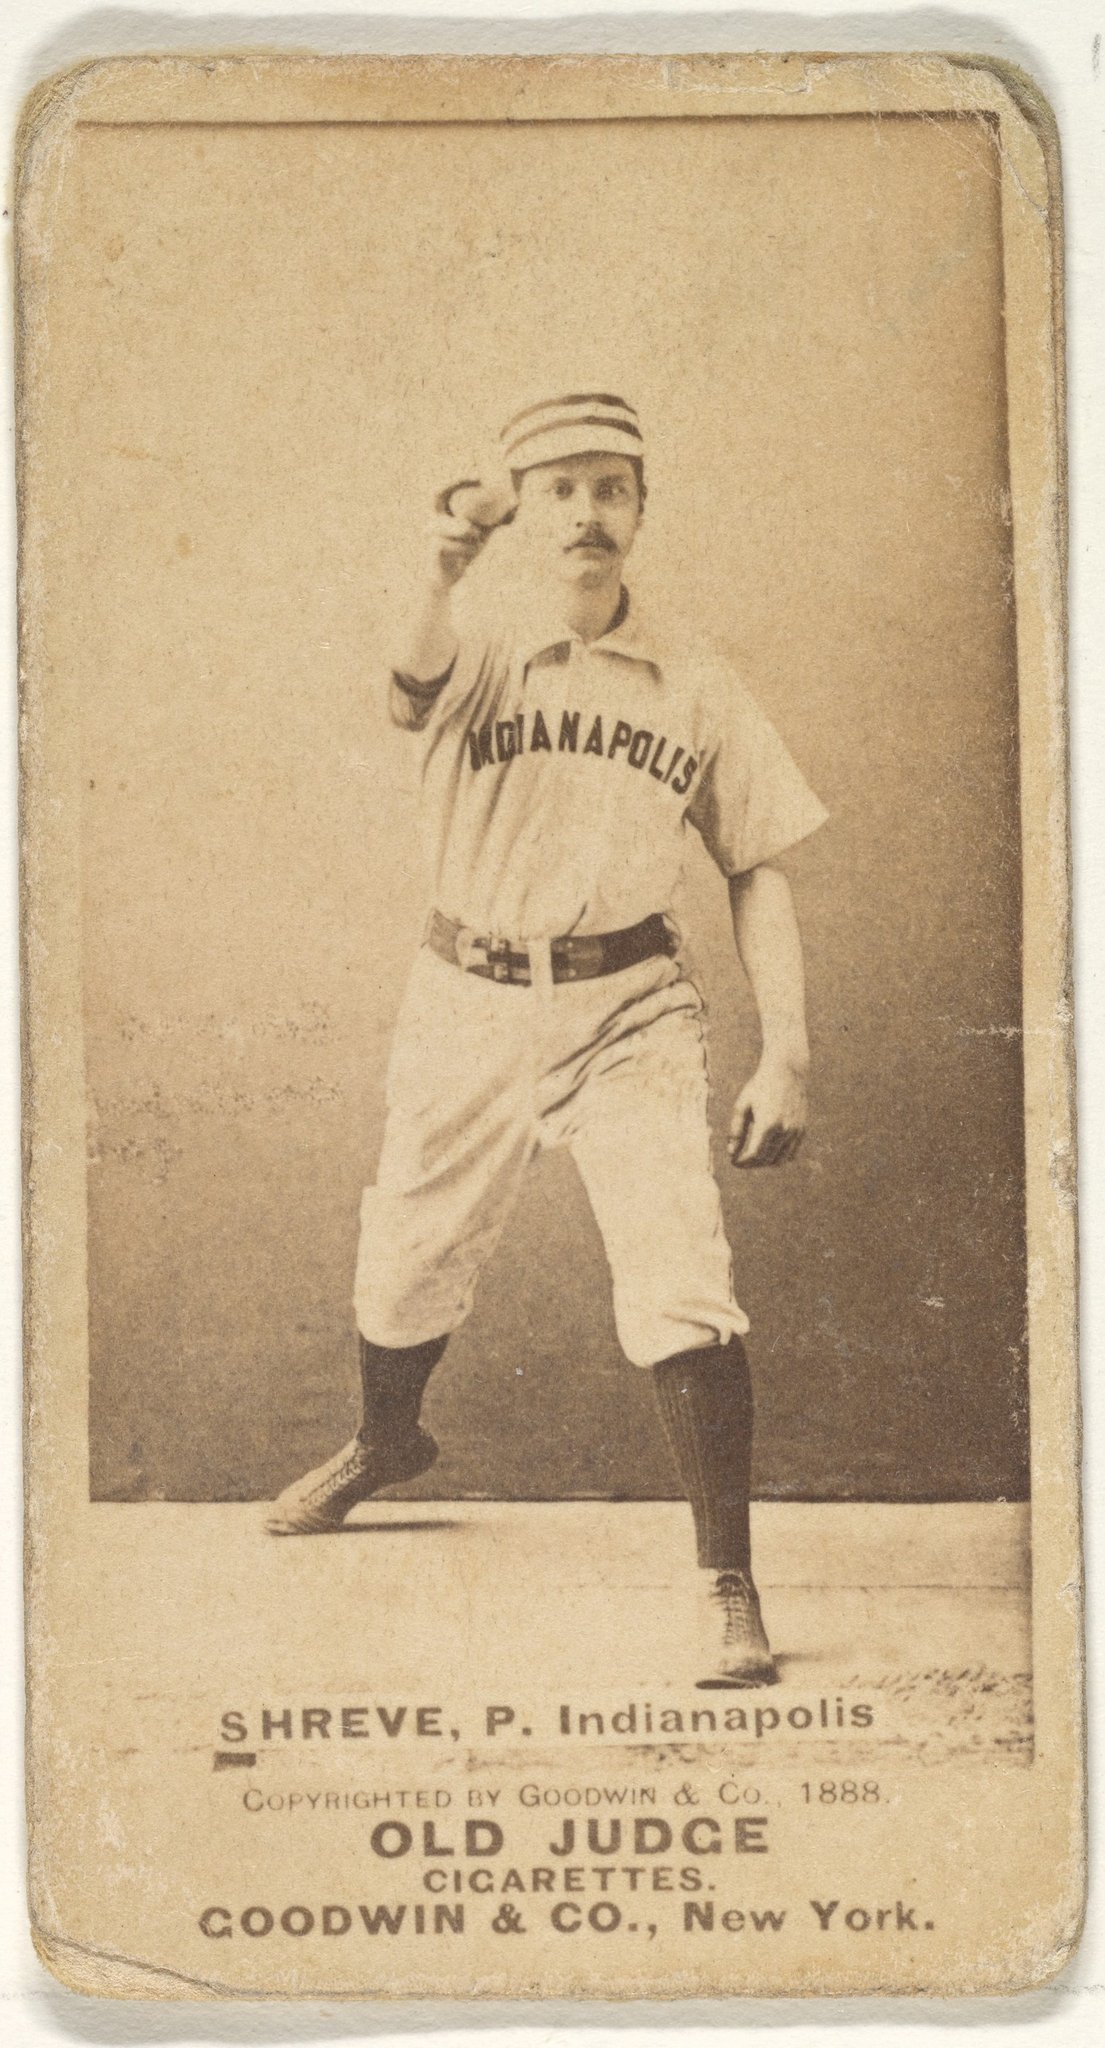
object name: baseball card, photograph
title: Lev Shreve, Pitcher, Indianapolis, from the Old Judge series (N172) for Old Judge Cigarettes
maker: goodwin & company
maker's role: publisher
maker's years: 1850-1950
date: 1888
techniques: albumen silver print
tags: men,portraits,baseball,athletes